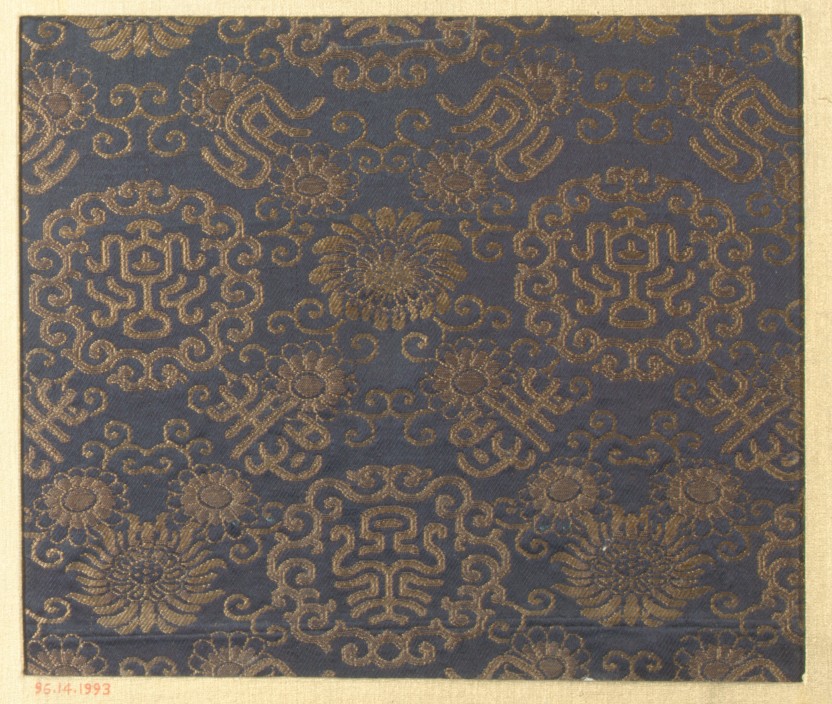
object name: piece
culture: japanese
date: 1701-1900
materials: silk